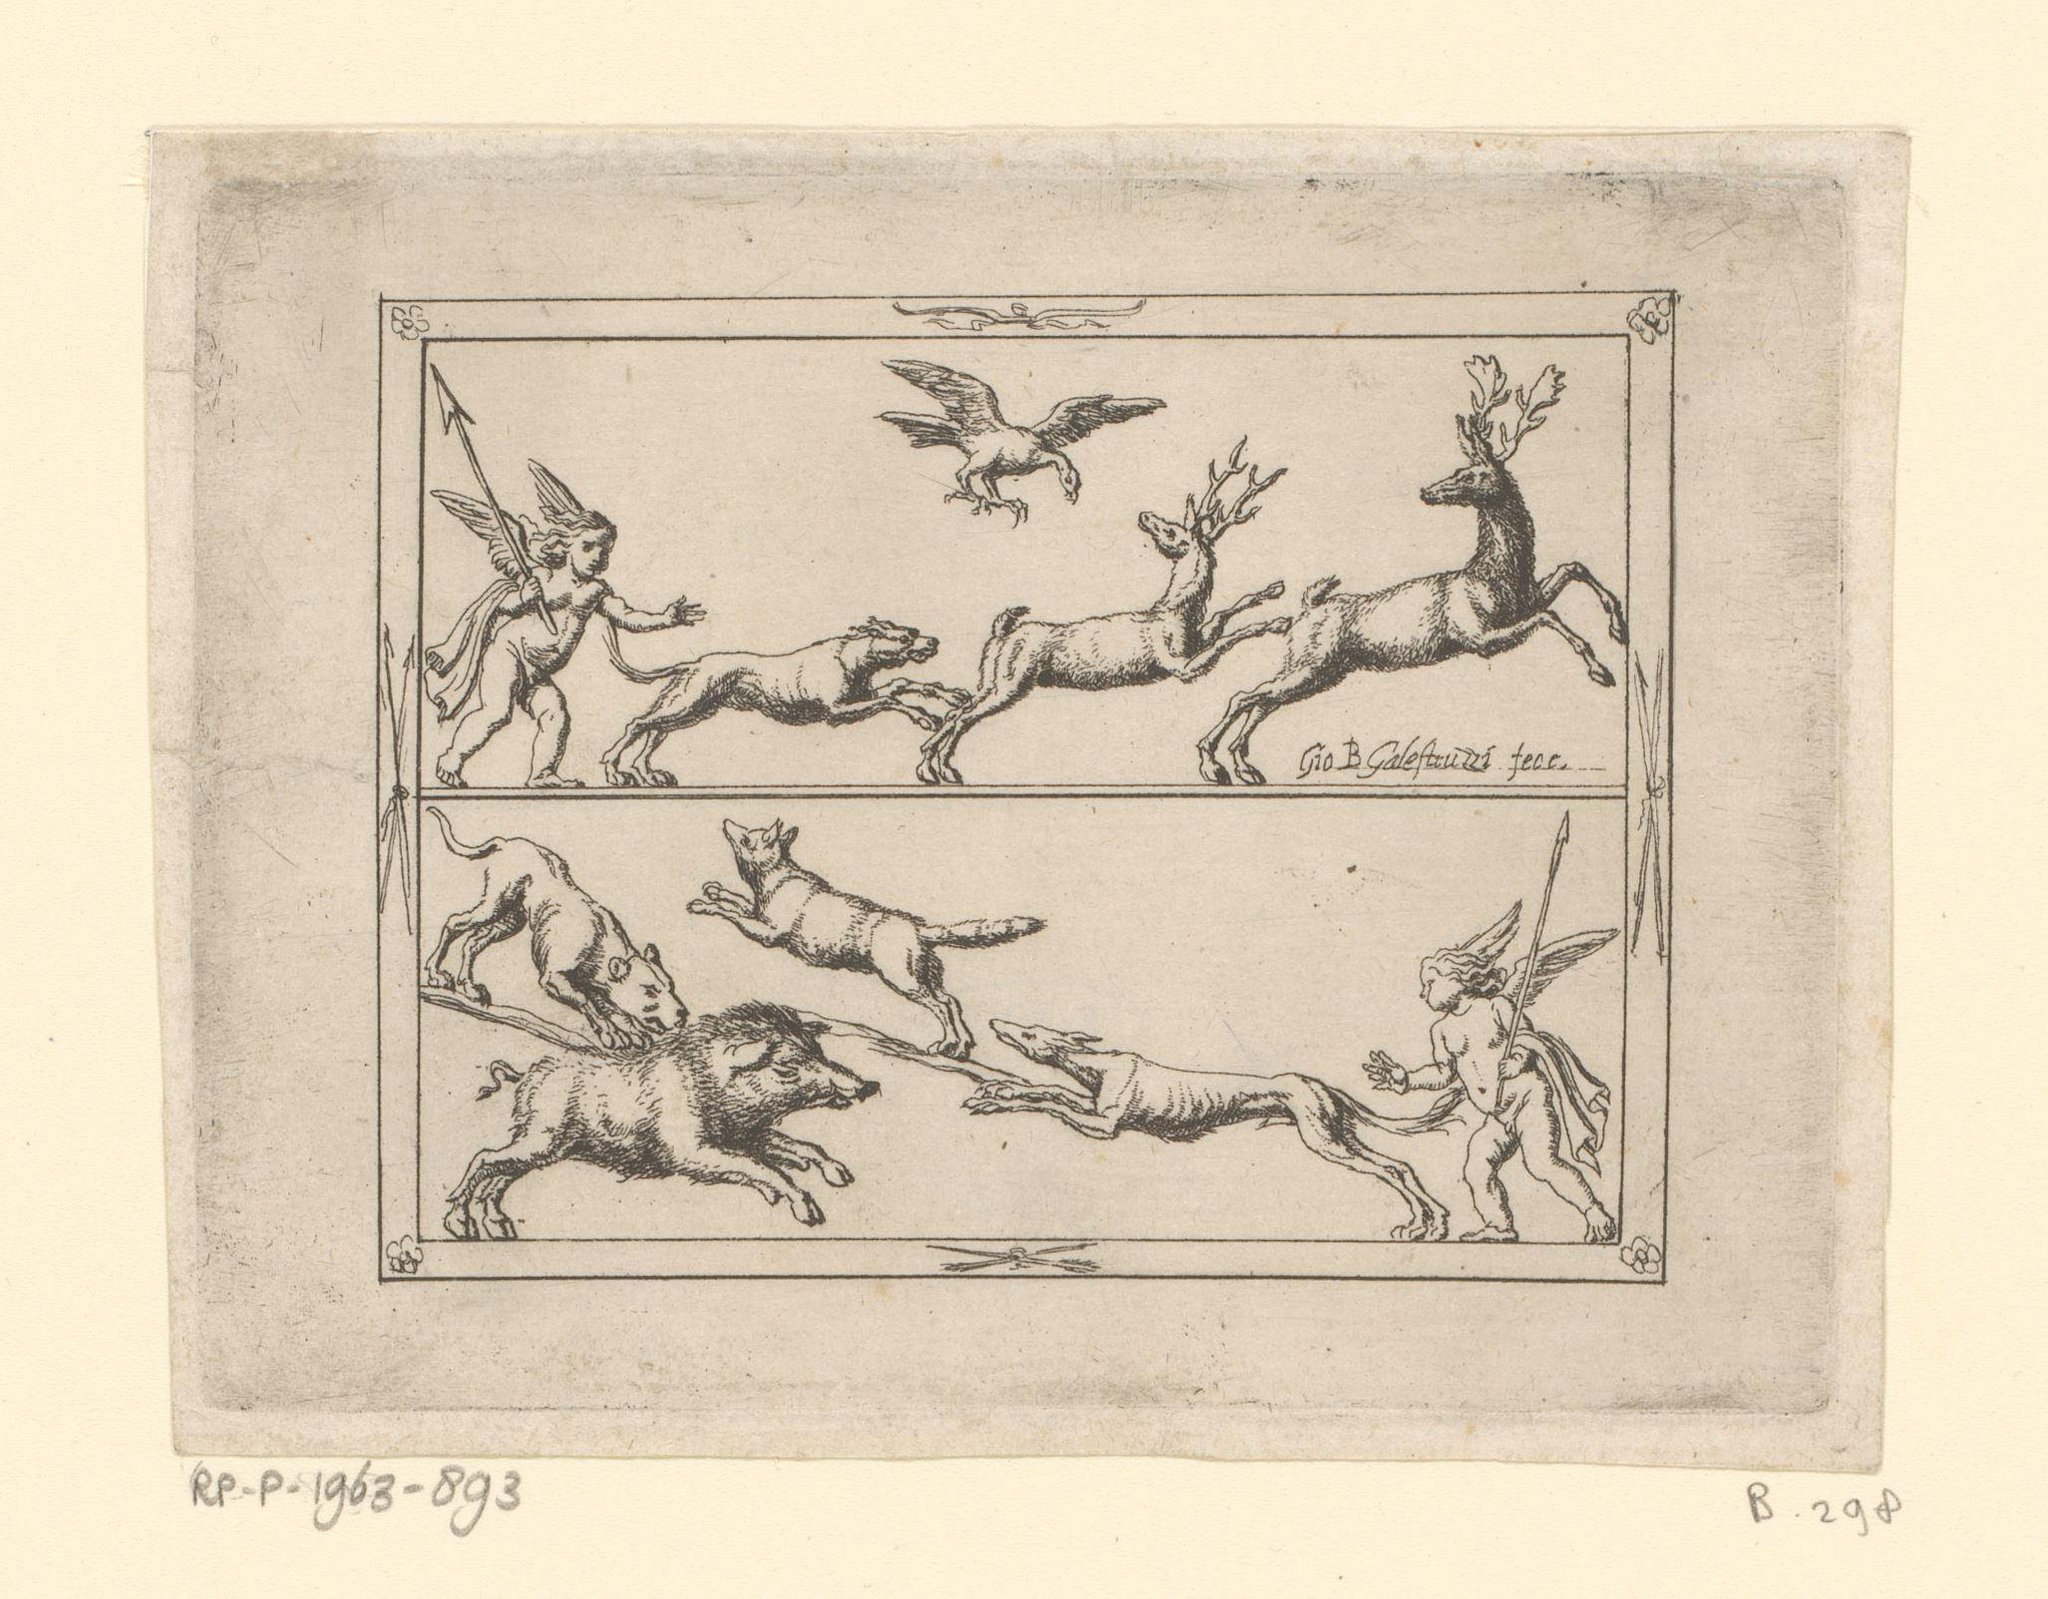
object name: print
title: Antieke figuratieve gemmen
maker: giovanni battista galestruzzi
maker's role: painter, print maker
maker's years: 1618-1661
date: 1625-1669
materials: paper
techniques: etching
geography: italy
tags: stag-hunting, hunting dogs, boar-hunting, fox hunting, hunt ~ mammals, cupids: 'amores', 'amoretti', 'putti'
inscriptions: collector's mark: Lugt 2760, collector's mark: Lugt 2228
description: Boven: een putto met een jachthond en een adelaar jagend op twee herten. Onder: een putto met een jachthond jagend op een vos, een poema en een everzwijn. Naar een antieke uit kristal gesneden gem.